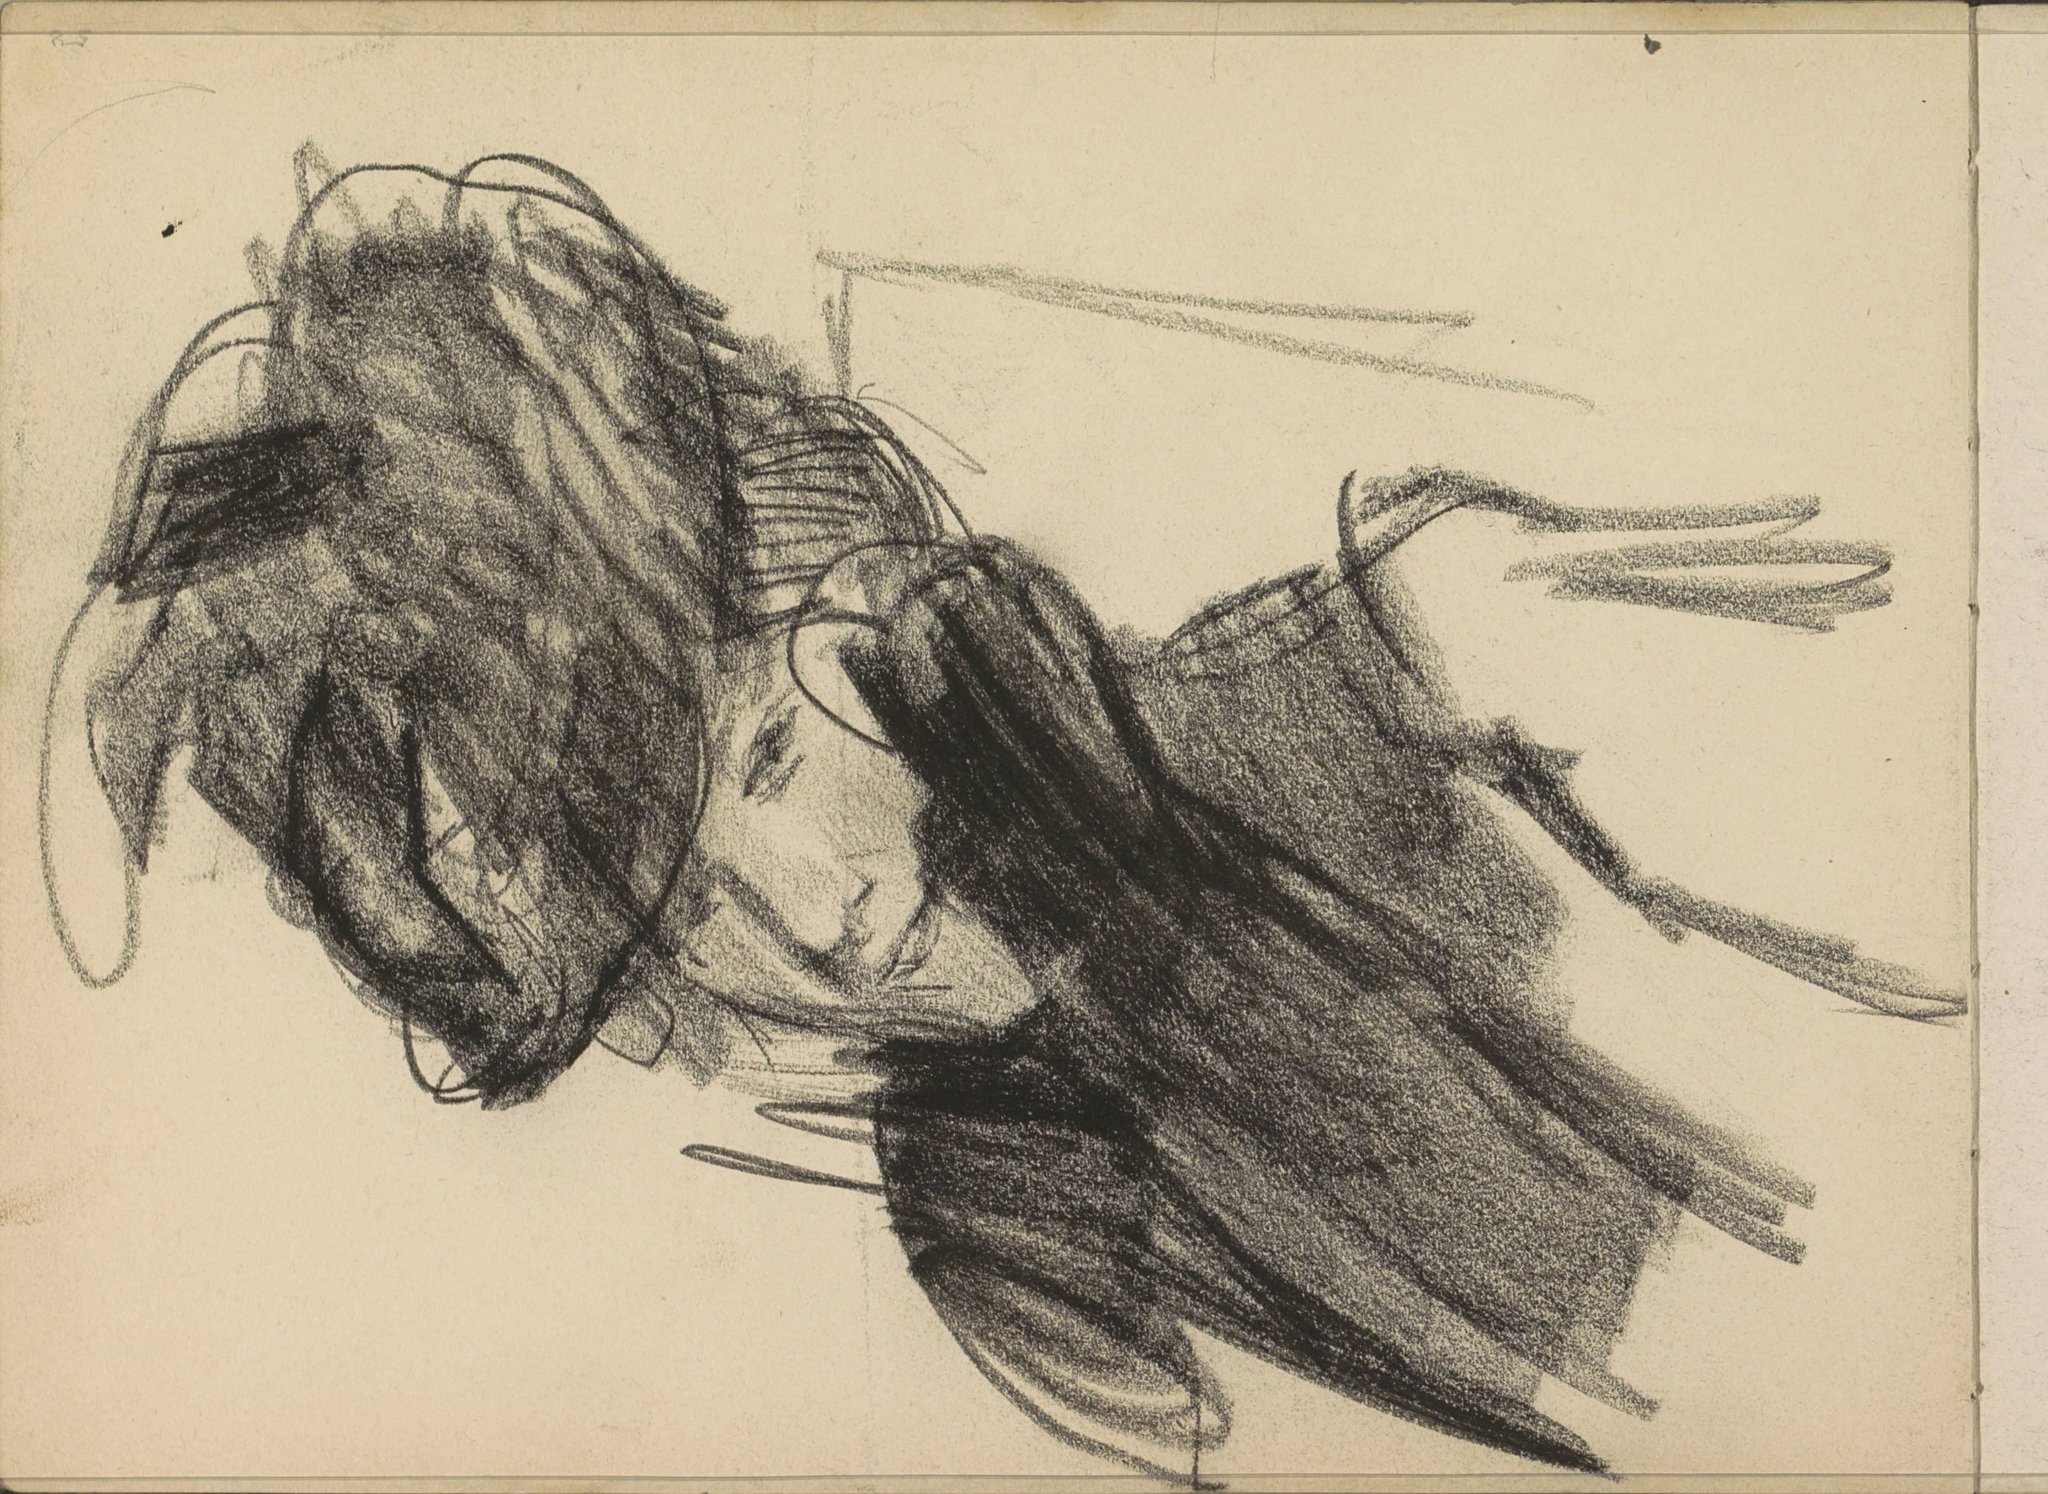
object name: sketchbook leaf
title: Vrouw met hoed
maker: isaac israels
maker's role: draughtsman, painter, print maker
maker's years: 1865-1934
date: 1890-1920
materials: chalk, paper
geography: the hague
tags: adult woman, head-gear: hat (+ women's clothes)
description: Blad 29 verso uit schetsboek X met 43 bladen.